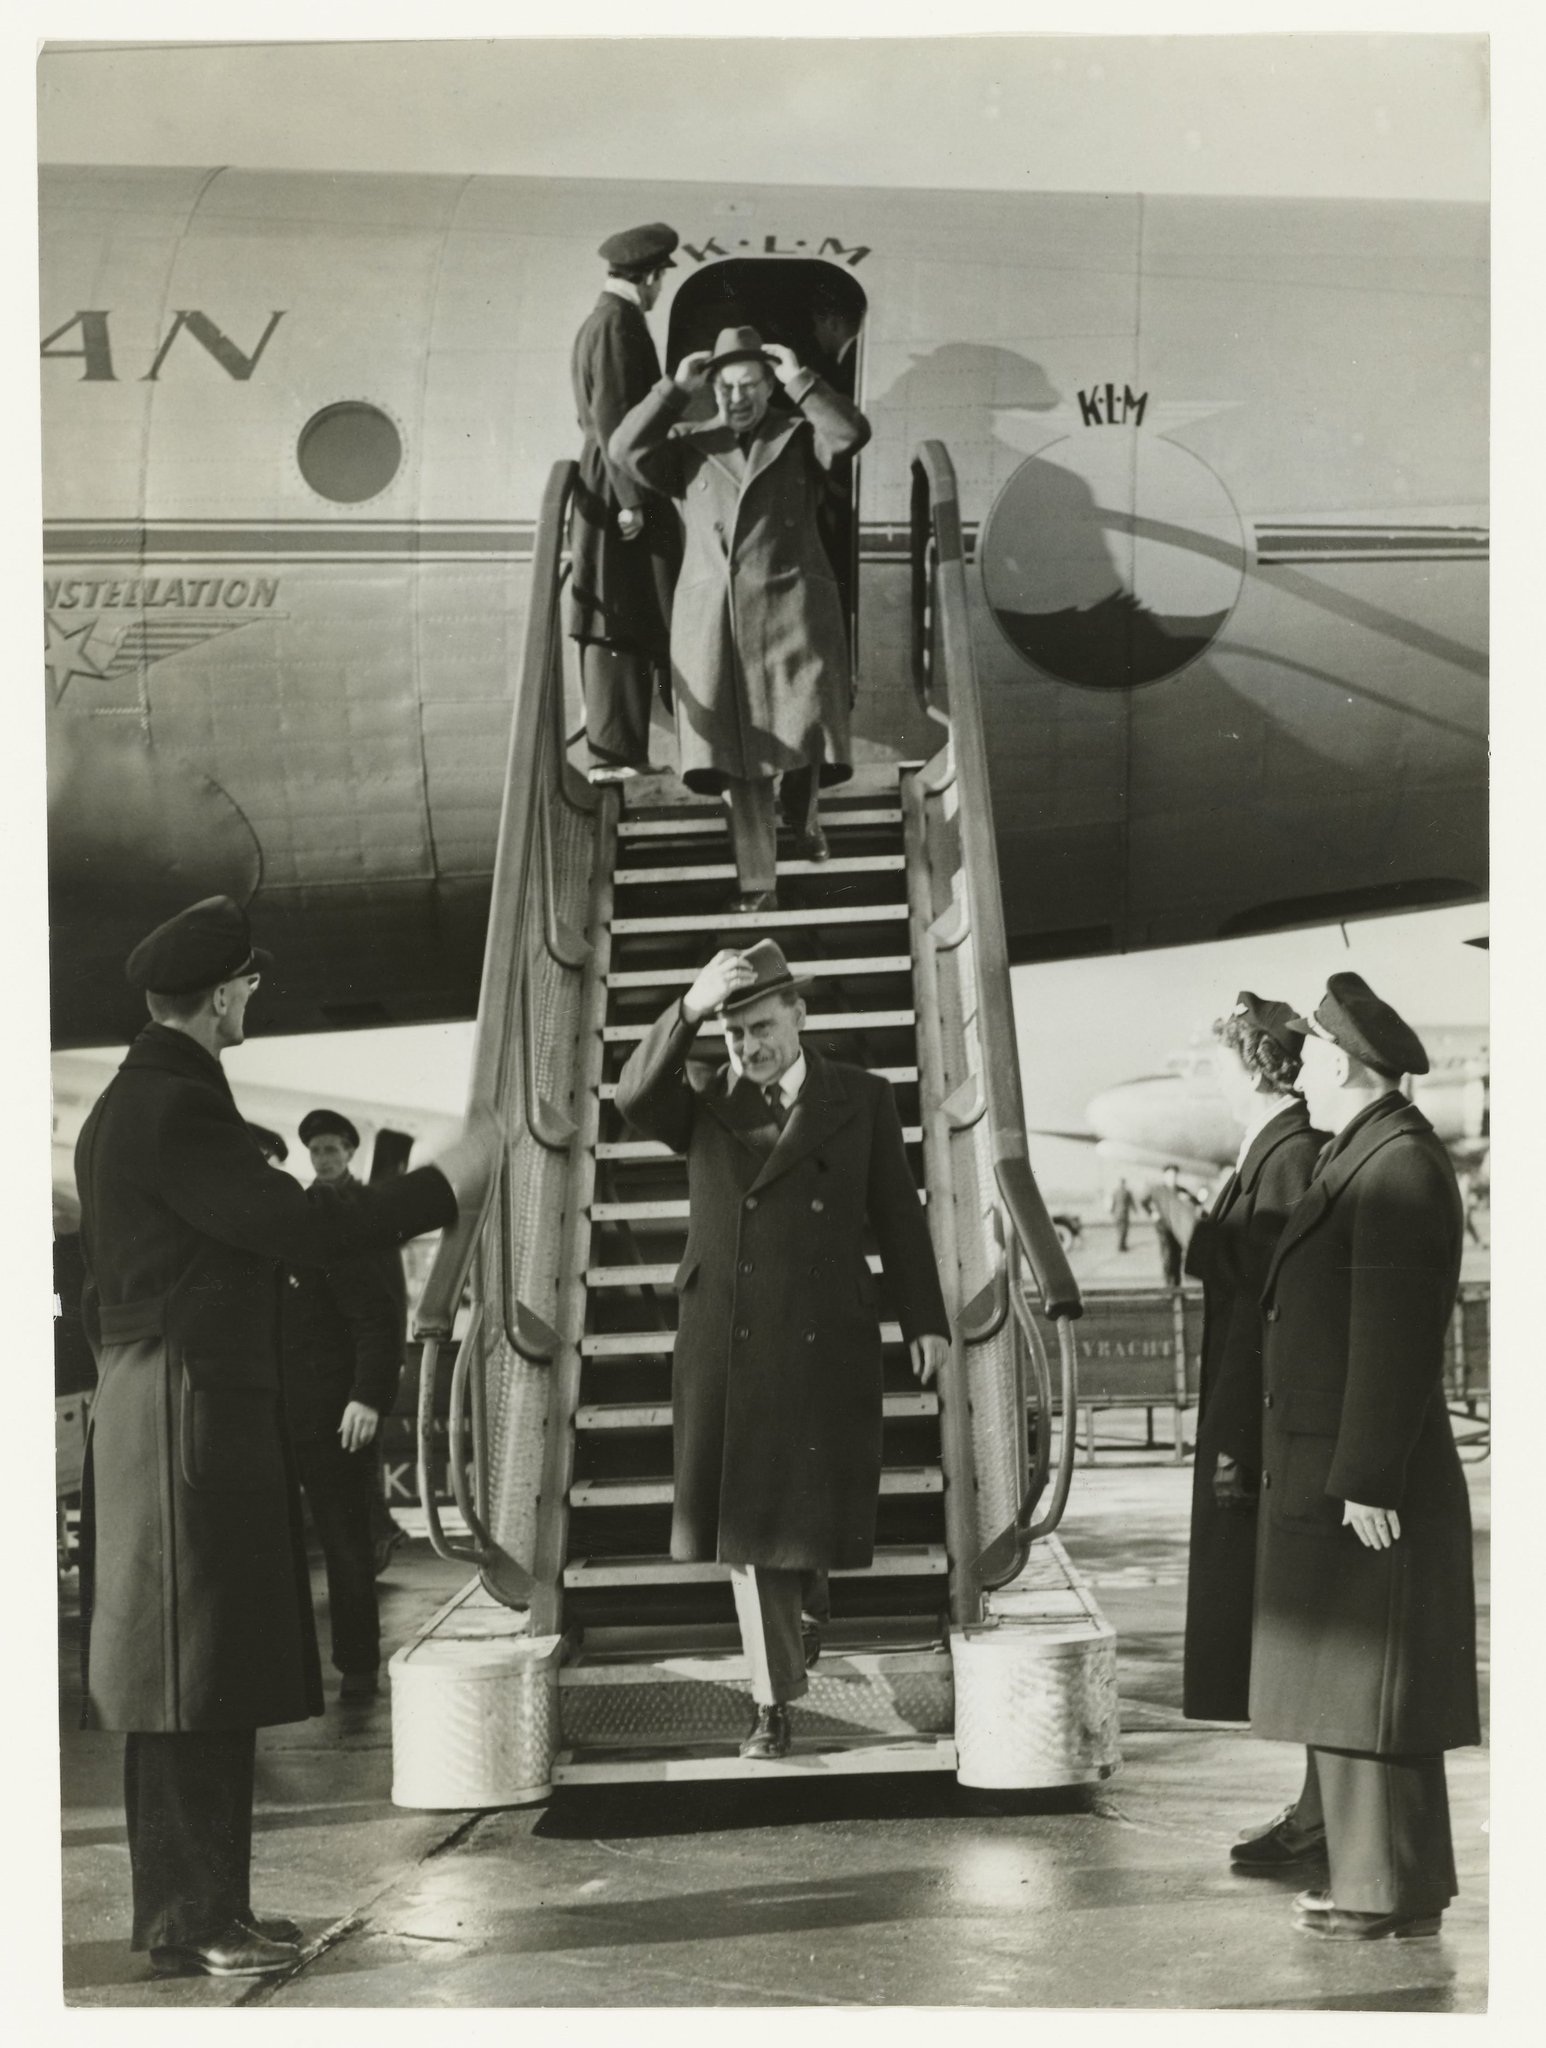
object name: documentary photograph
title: Minister Drees verlaat een vliegtuig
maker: Anonymous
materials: photographic support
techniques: photography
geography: schiphol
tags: amsterdam, willem drees, indonesia